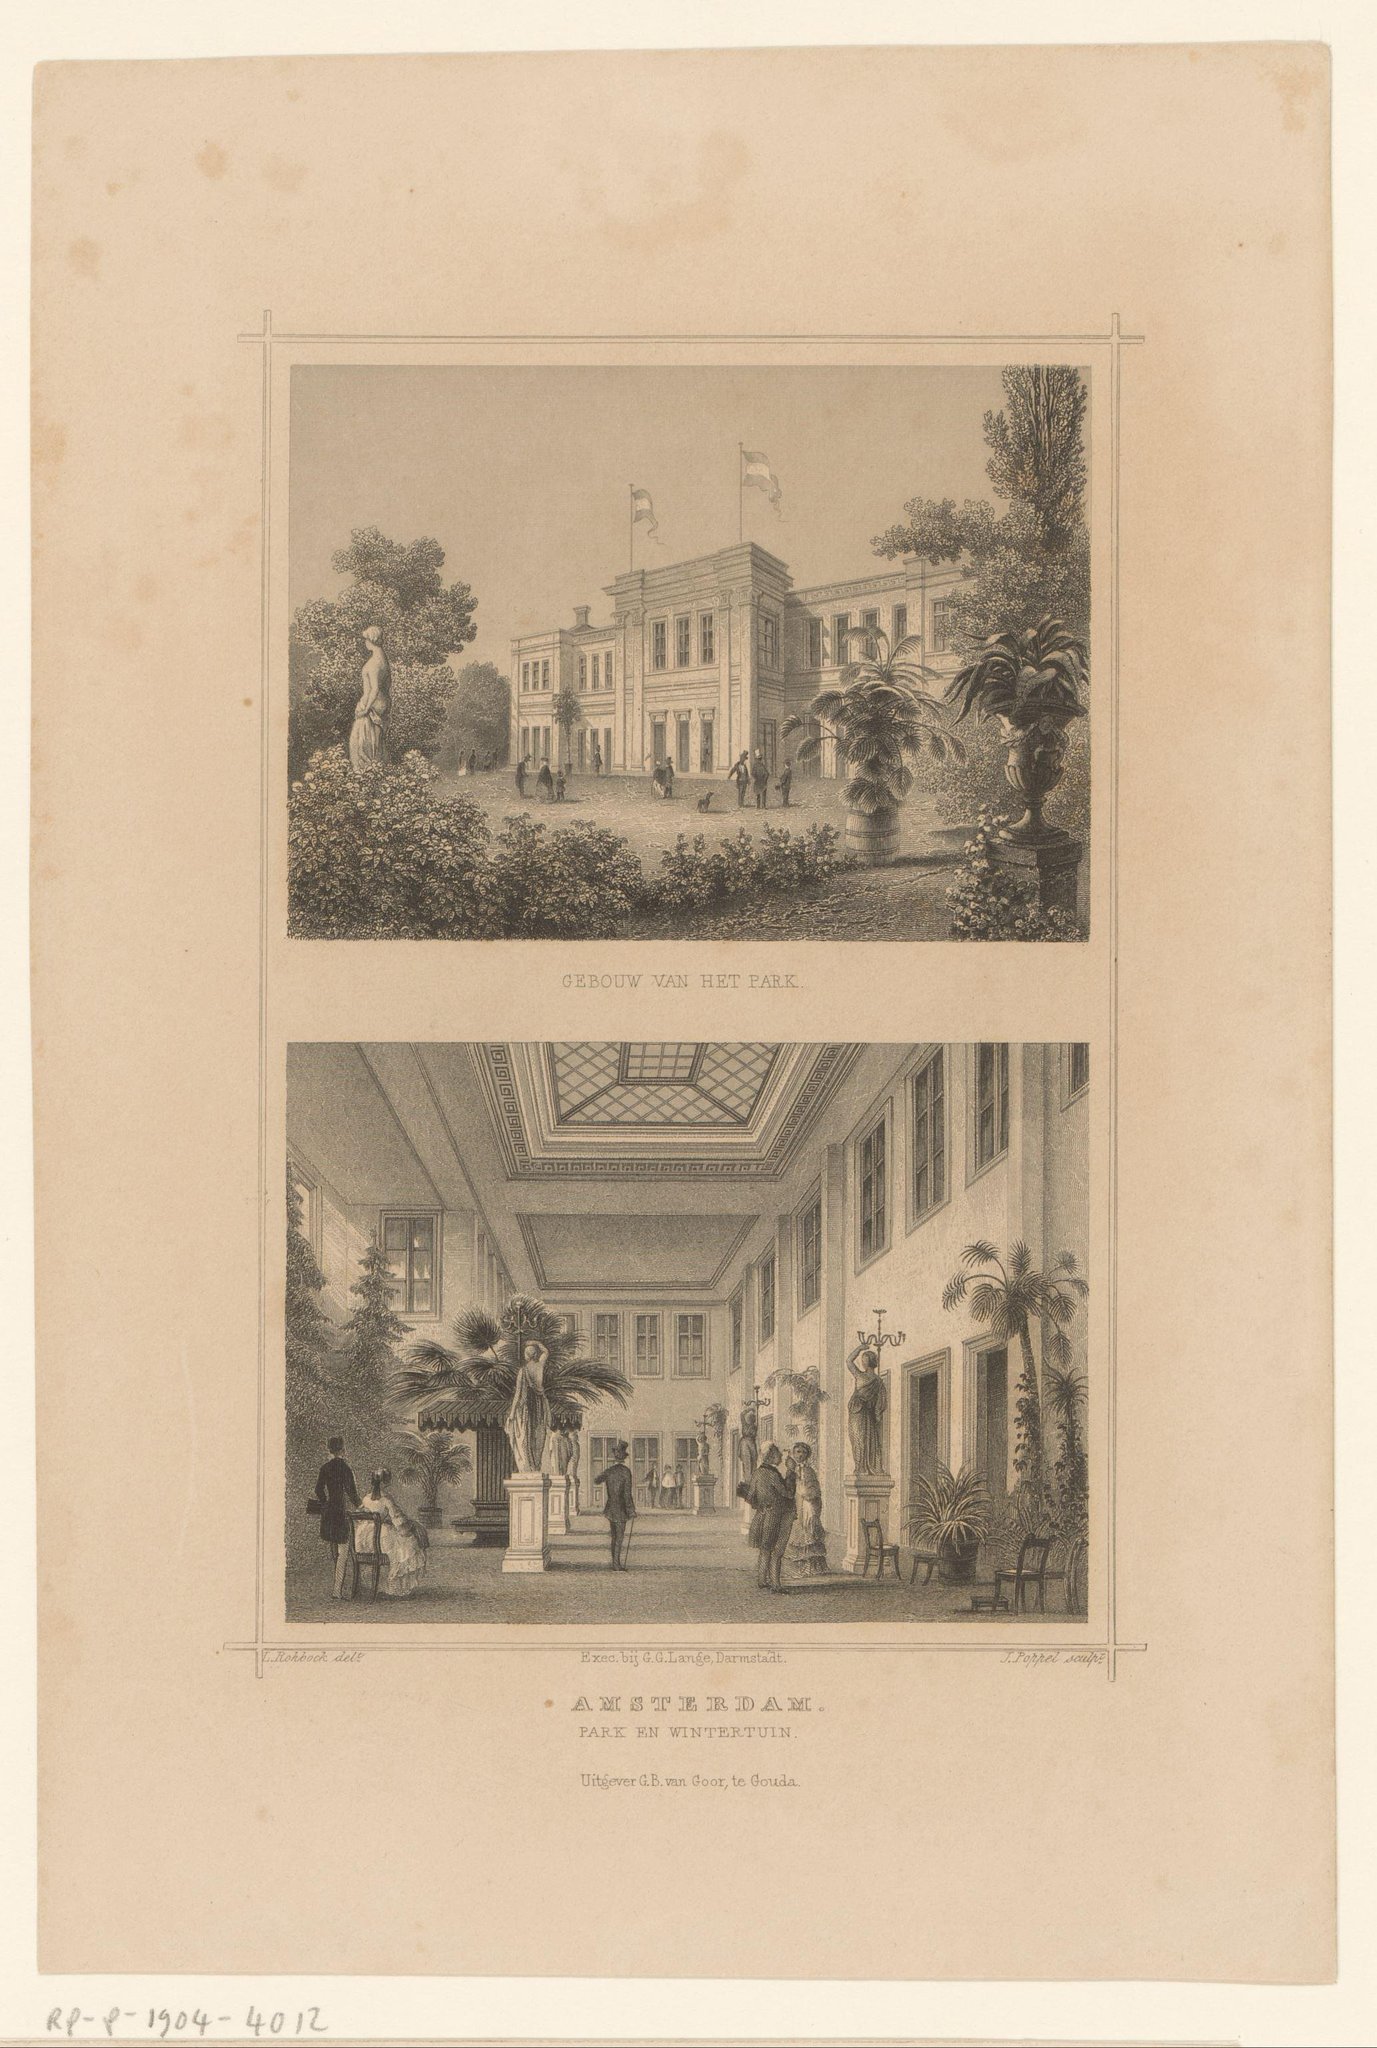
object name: print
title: Exterieur en interieur van Het Park in Amsterdam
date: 1858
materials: paper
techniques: engraving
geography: gouda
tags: city-view, and landscape with man-made constructions, winter-garden, conservatory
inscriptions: collector's mark: Lugt 2228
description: Prent ook gebruikt in: Terwen, Johannes Leonardus. Het Koningrijk der Nederlanden voorgesteld in eene reeks van naar de natuur geteekende schilderachtige gezigten. Gouda: Van Goor, 1858-1862.